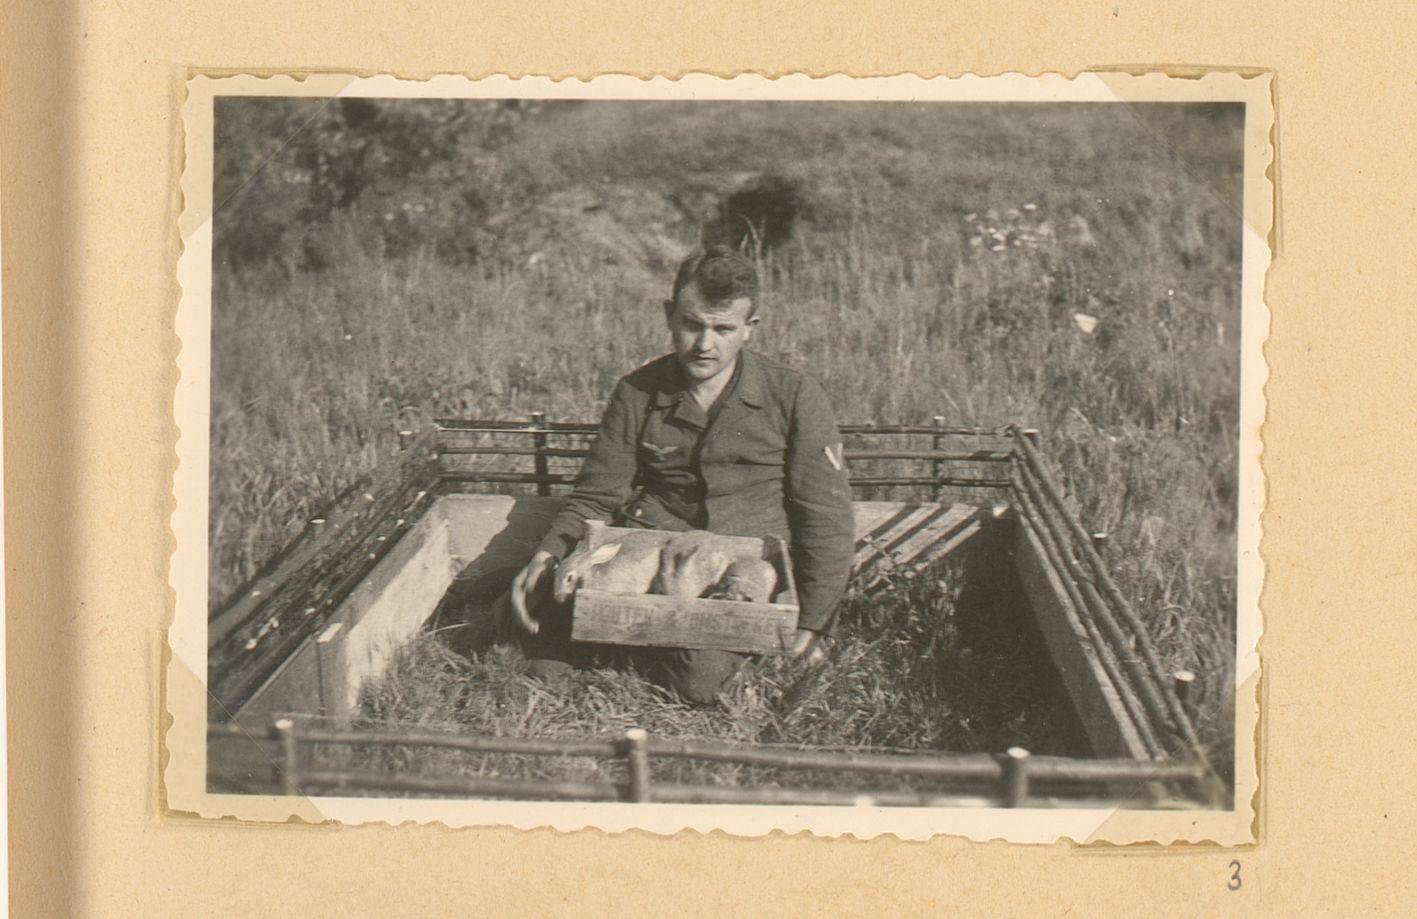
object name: photograph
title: Militair in het konijnenhok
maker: Anonymous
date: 1940-1944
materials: photographic support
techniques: gelatin silver print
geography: netherlands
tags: netherlands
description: Duitse militair op zijn knieën met een kistje waarin drie konijnen. Vermoedelijk gaan de konijnen de pan in. Foto op pagina 13 in fotoalbum Bewaking bunkers.